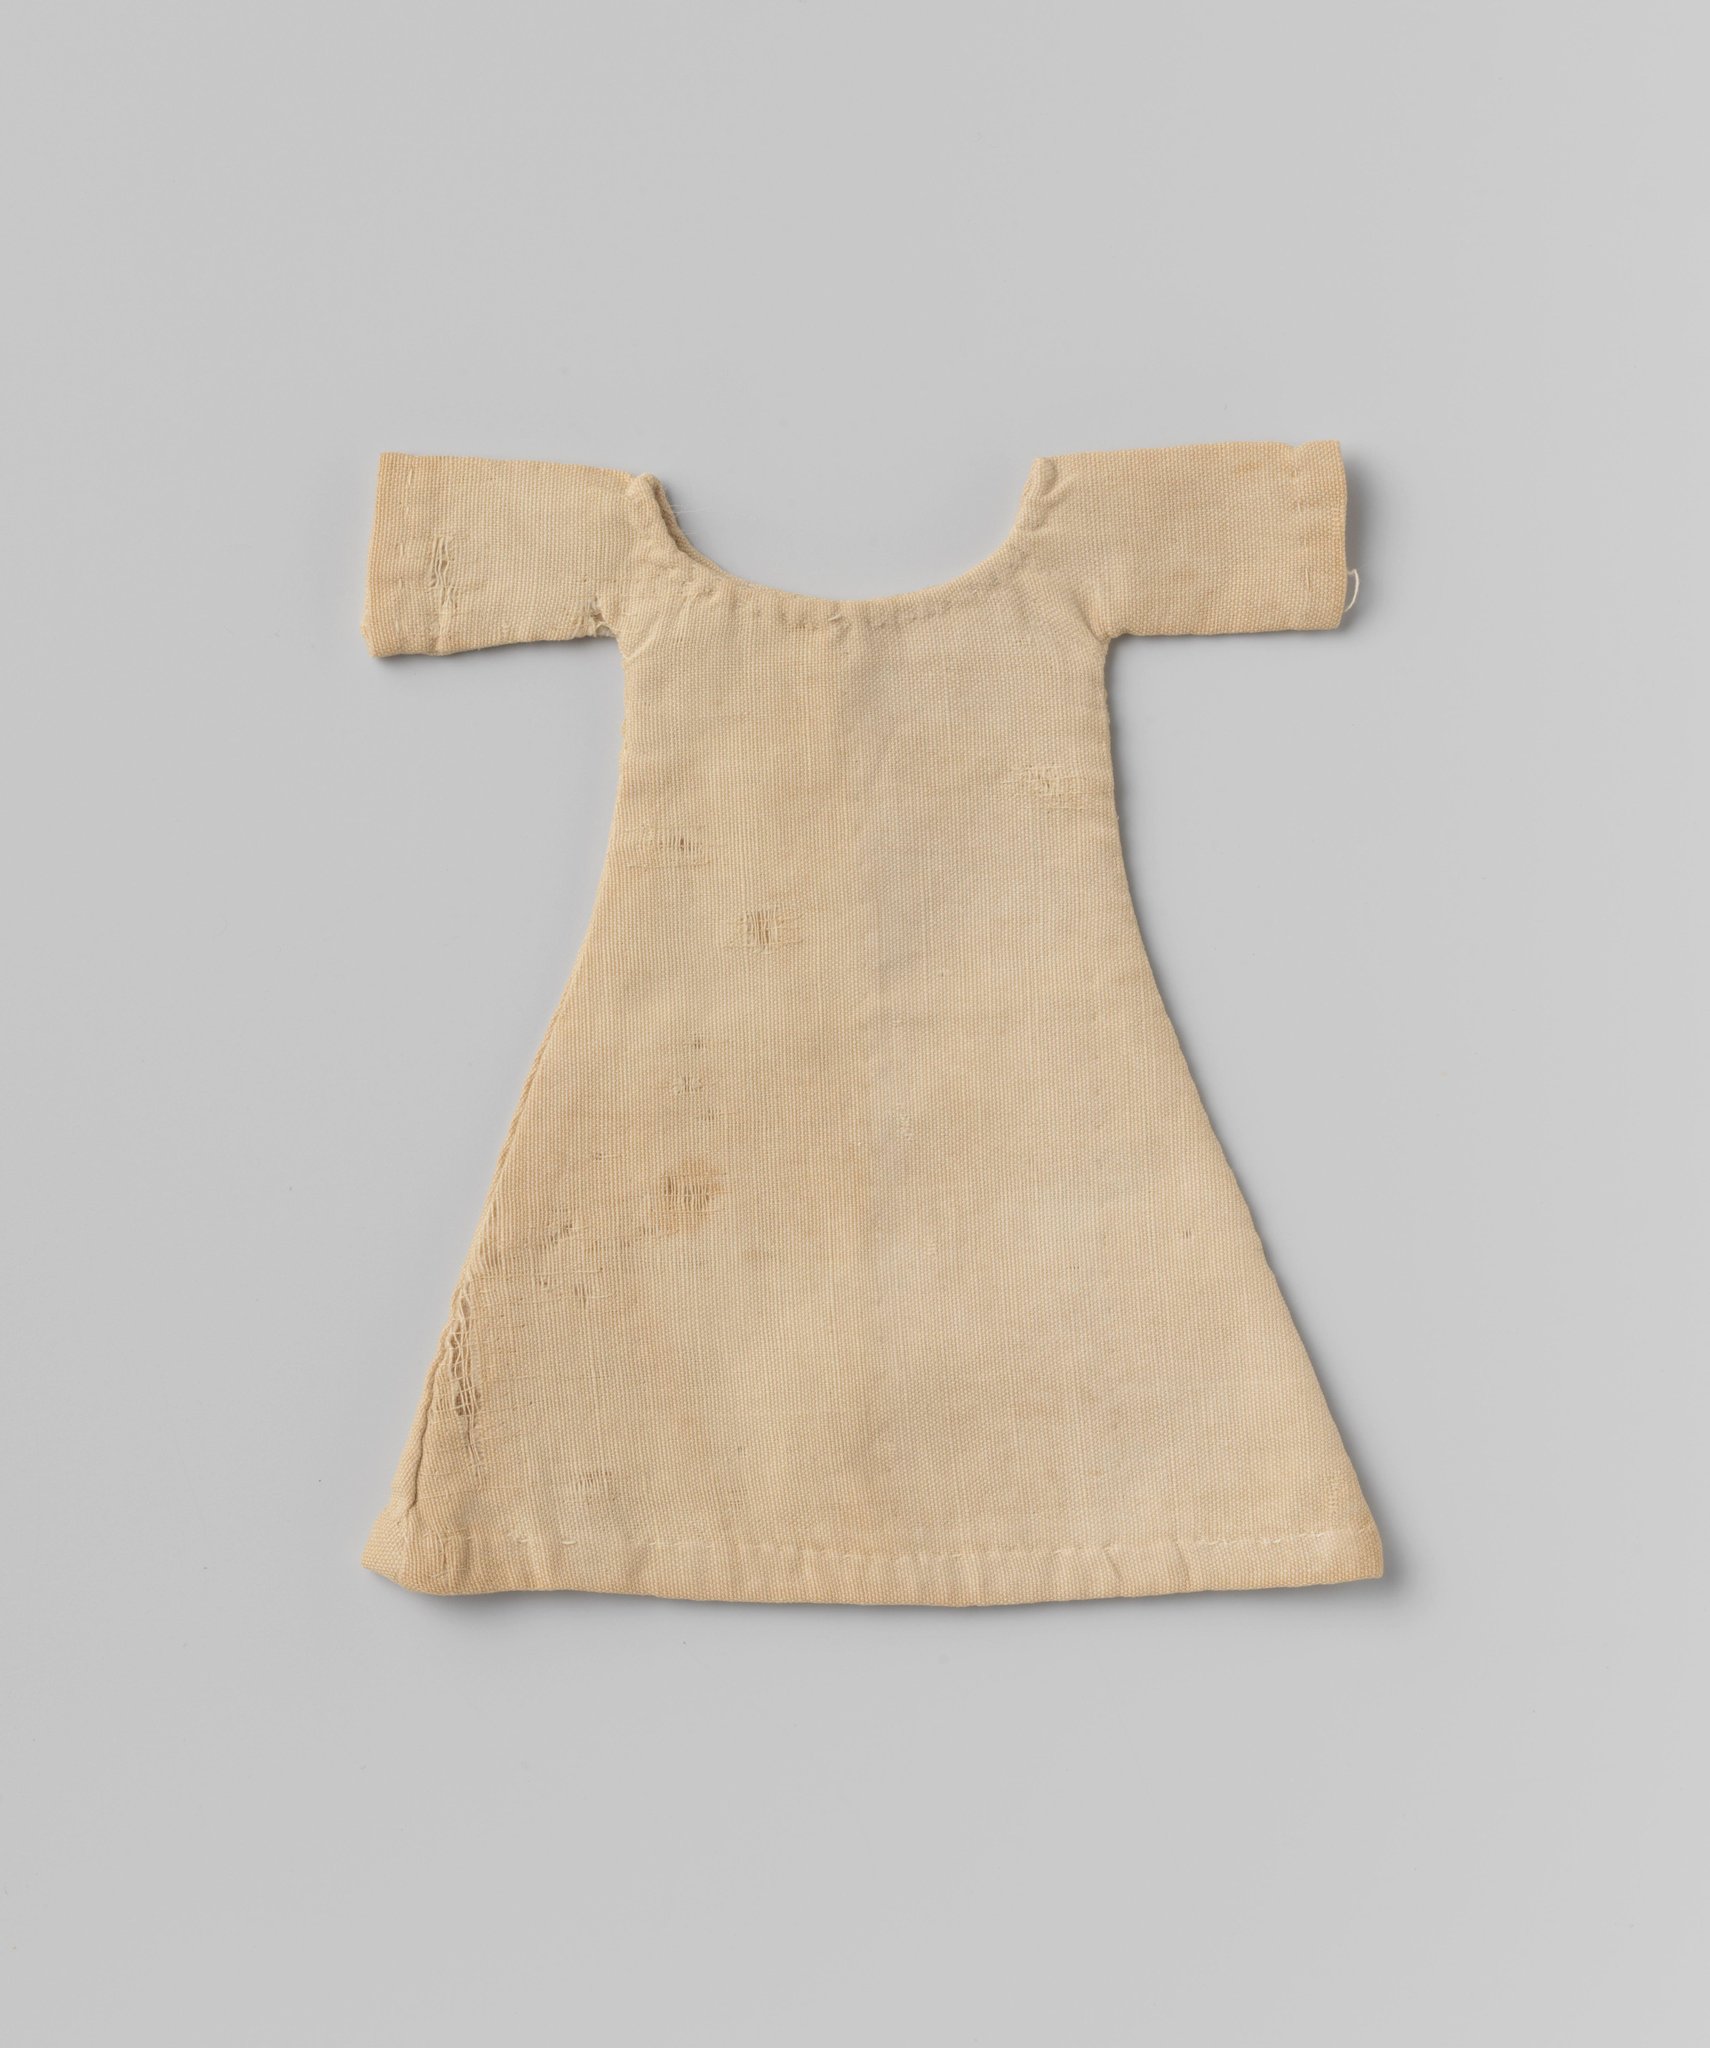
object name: miniature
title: Hemd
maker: Anonymous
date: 1750-1800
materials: cotton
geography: netherlands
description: Een lange hemd (voor man, vrouw, kind?) van grof katoen en slordig afgemaakt.